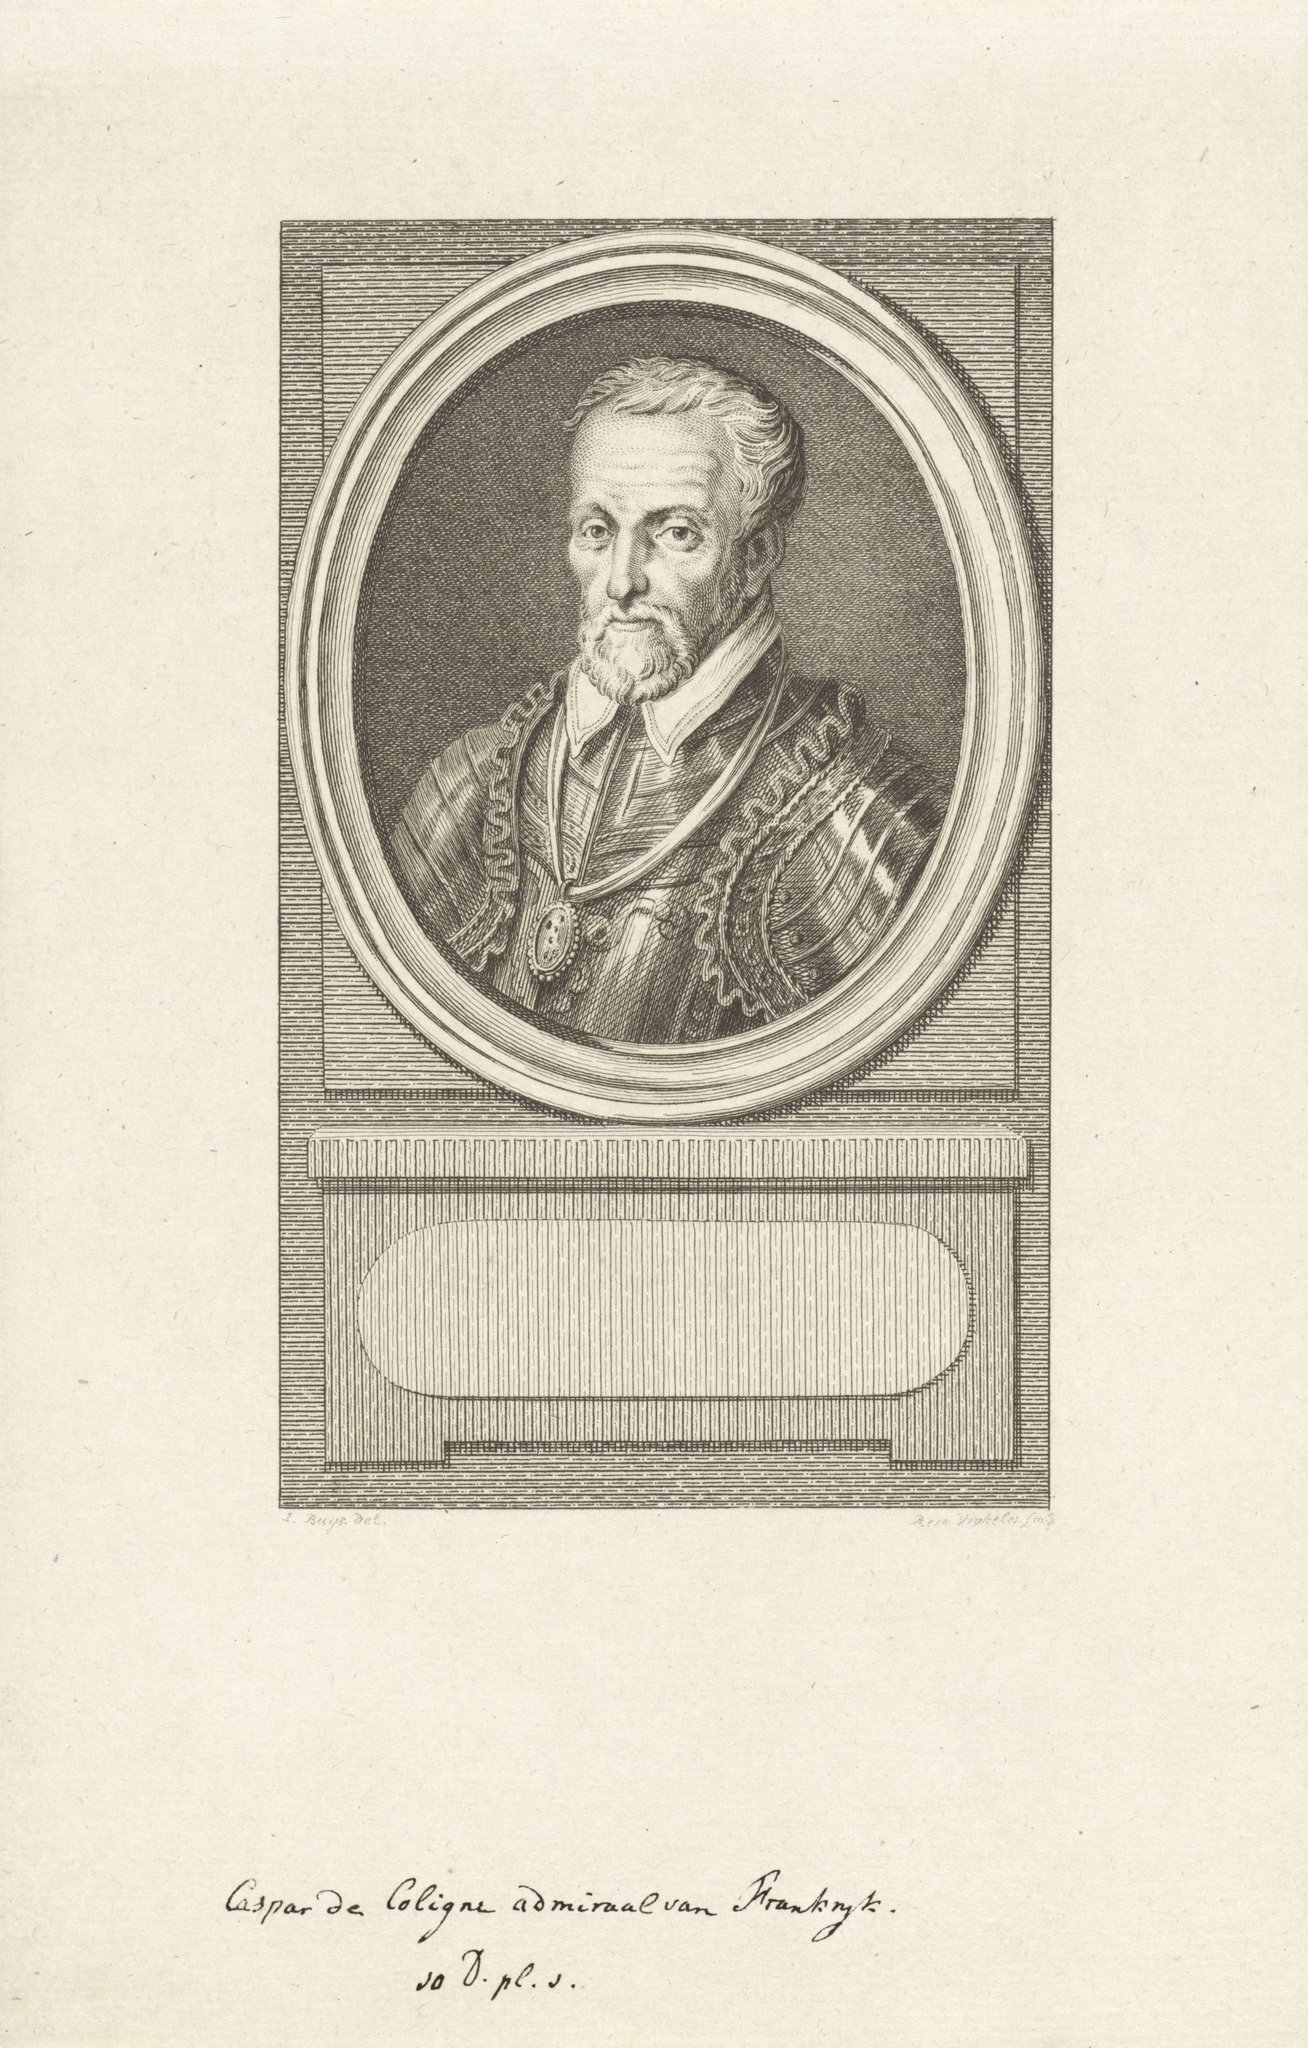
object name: print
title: Portret van Gaspard de Coligny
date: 1788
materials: paper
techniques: etching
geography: amsterdam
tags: paris, politician, gaspard de coligny (ii)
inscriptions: inscription: ‘Caspar de Coligne admiraal van Frankrijk 10 D. p. 1.’, collector's mark: Lugt 240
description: Latere staat prent gebruikt als boekillustratie in: Kok, Jacobus. Vaderlandsch woordenboek : met kaarten, plaaten en pourtraitten. Amsterdam: Johannes Allart, 1785-1796. Deel X.